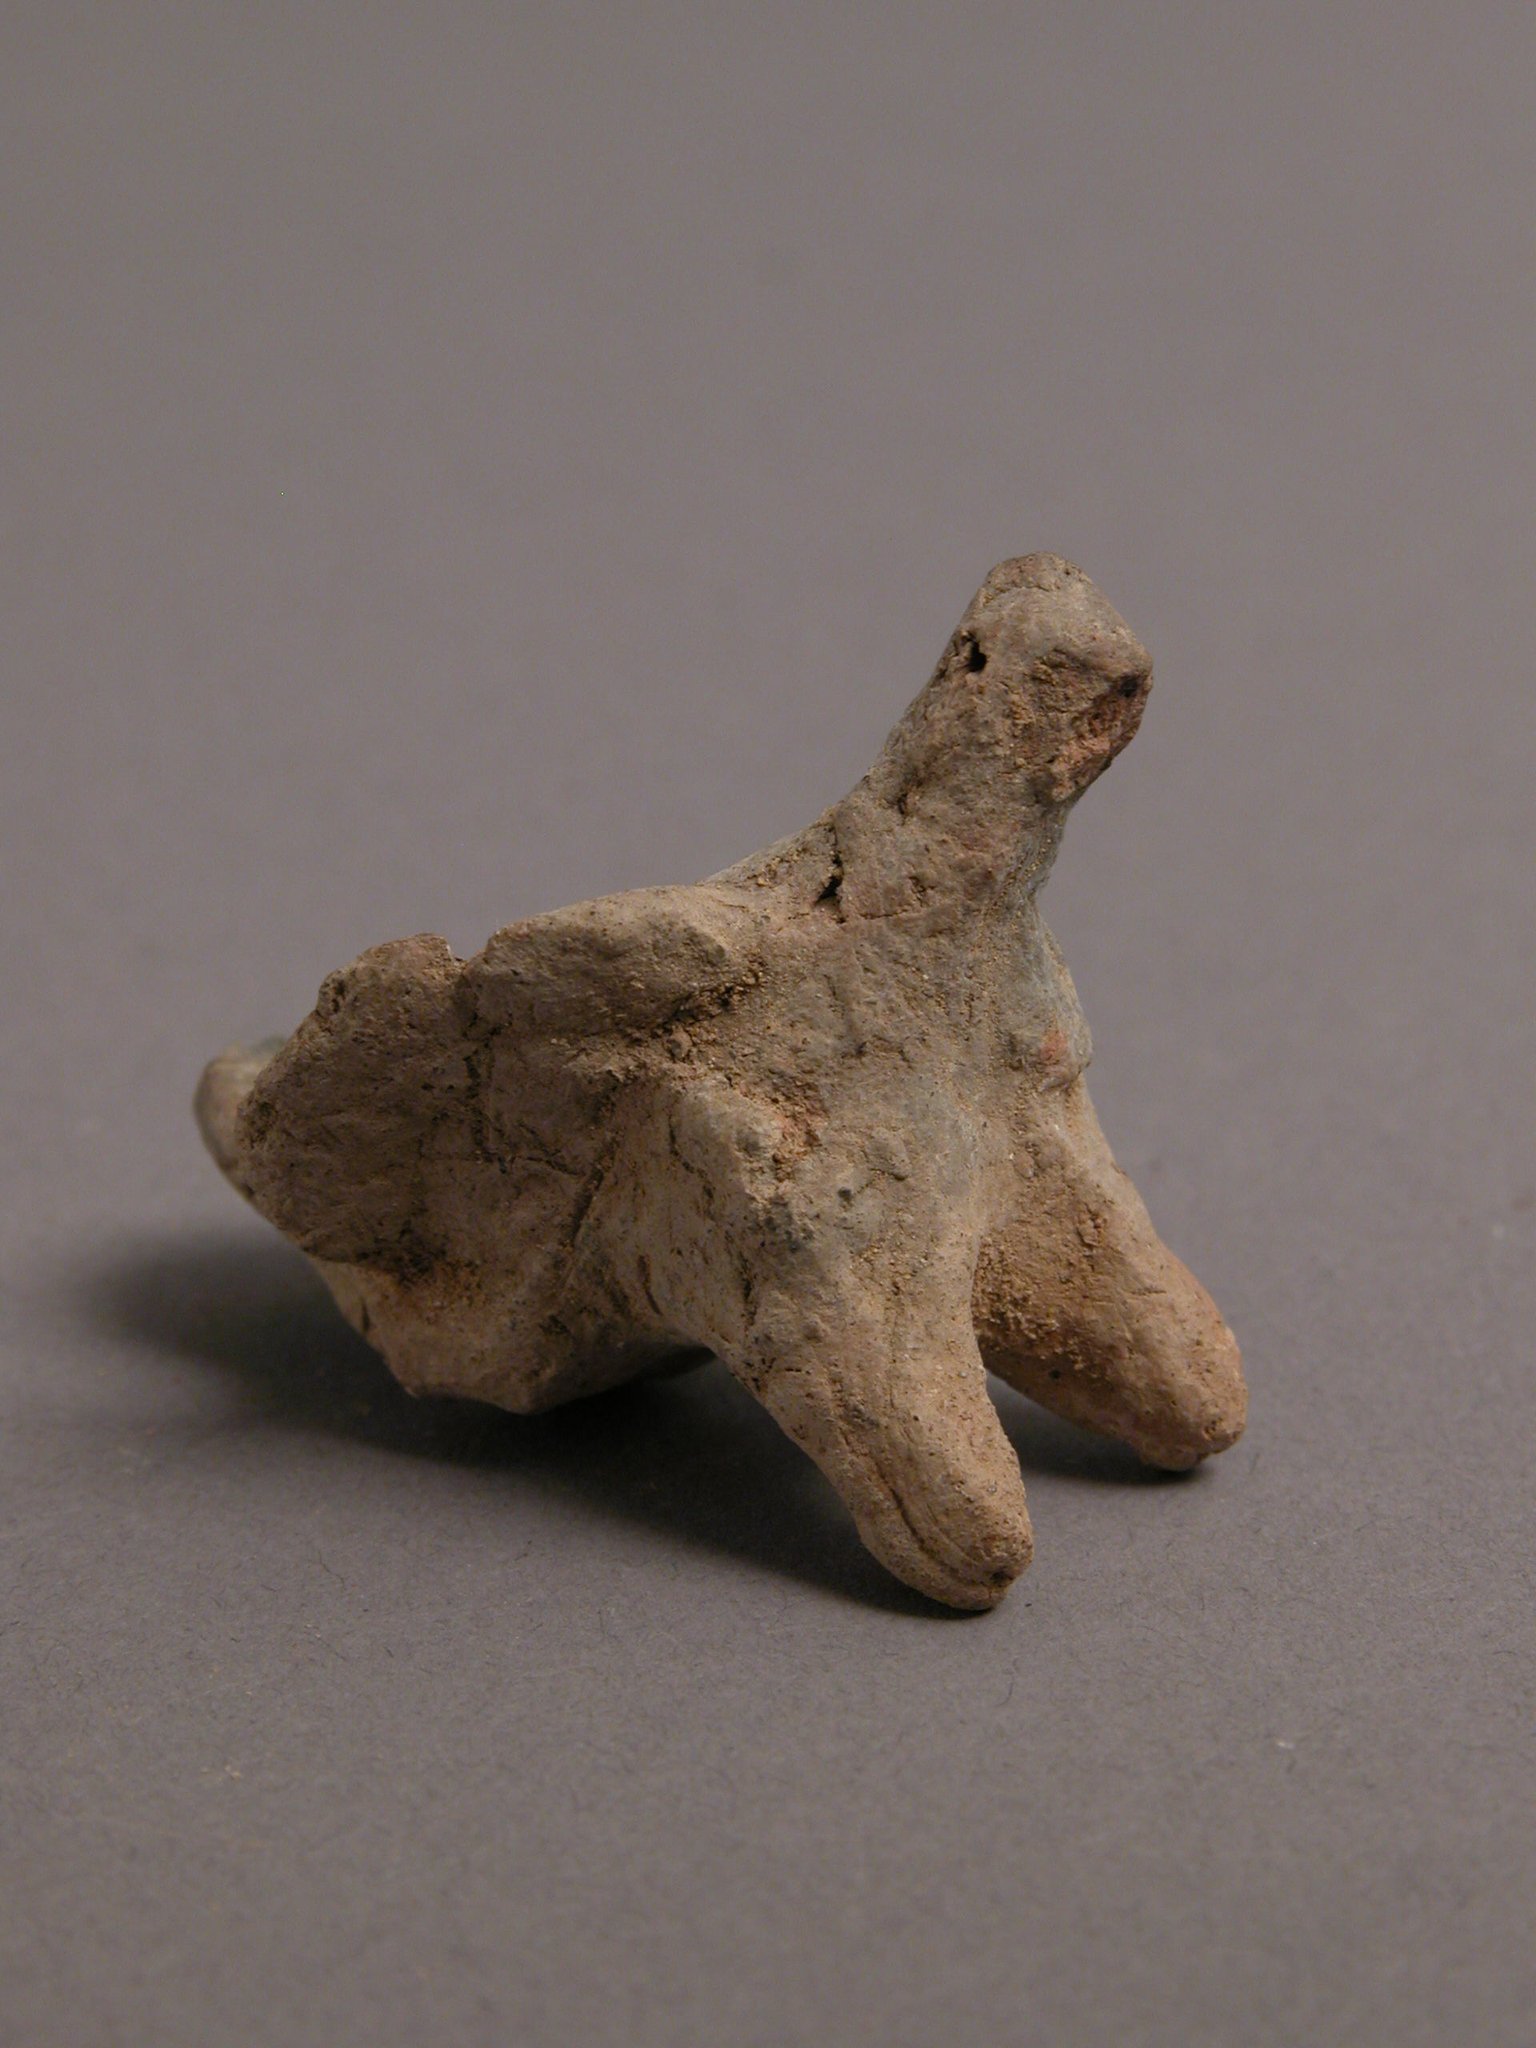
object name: statuette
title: Bird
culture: coptic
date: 301-700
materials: earthenware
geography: egypt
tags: birds